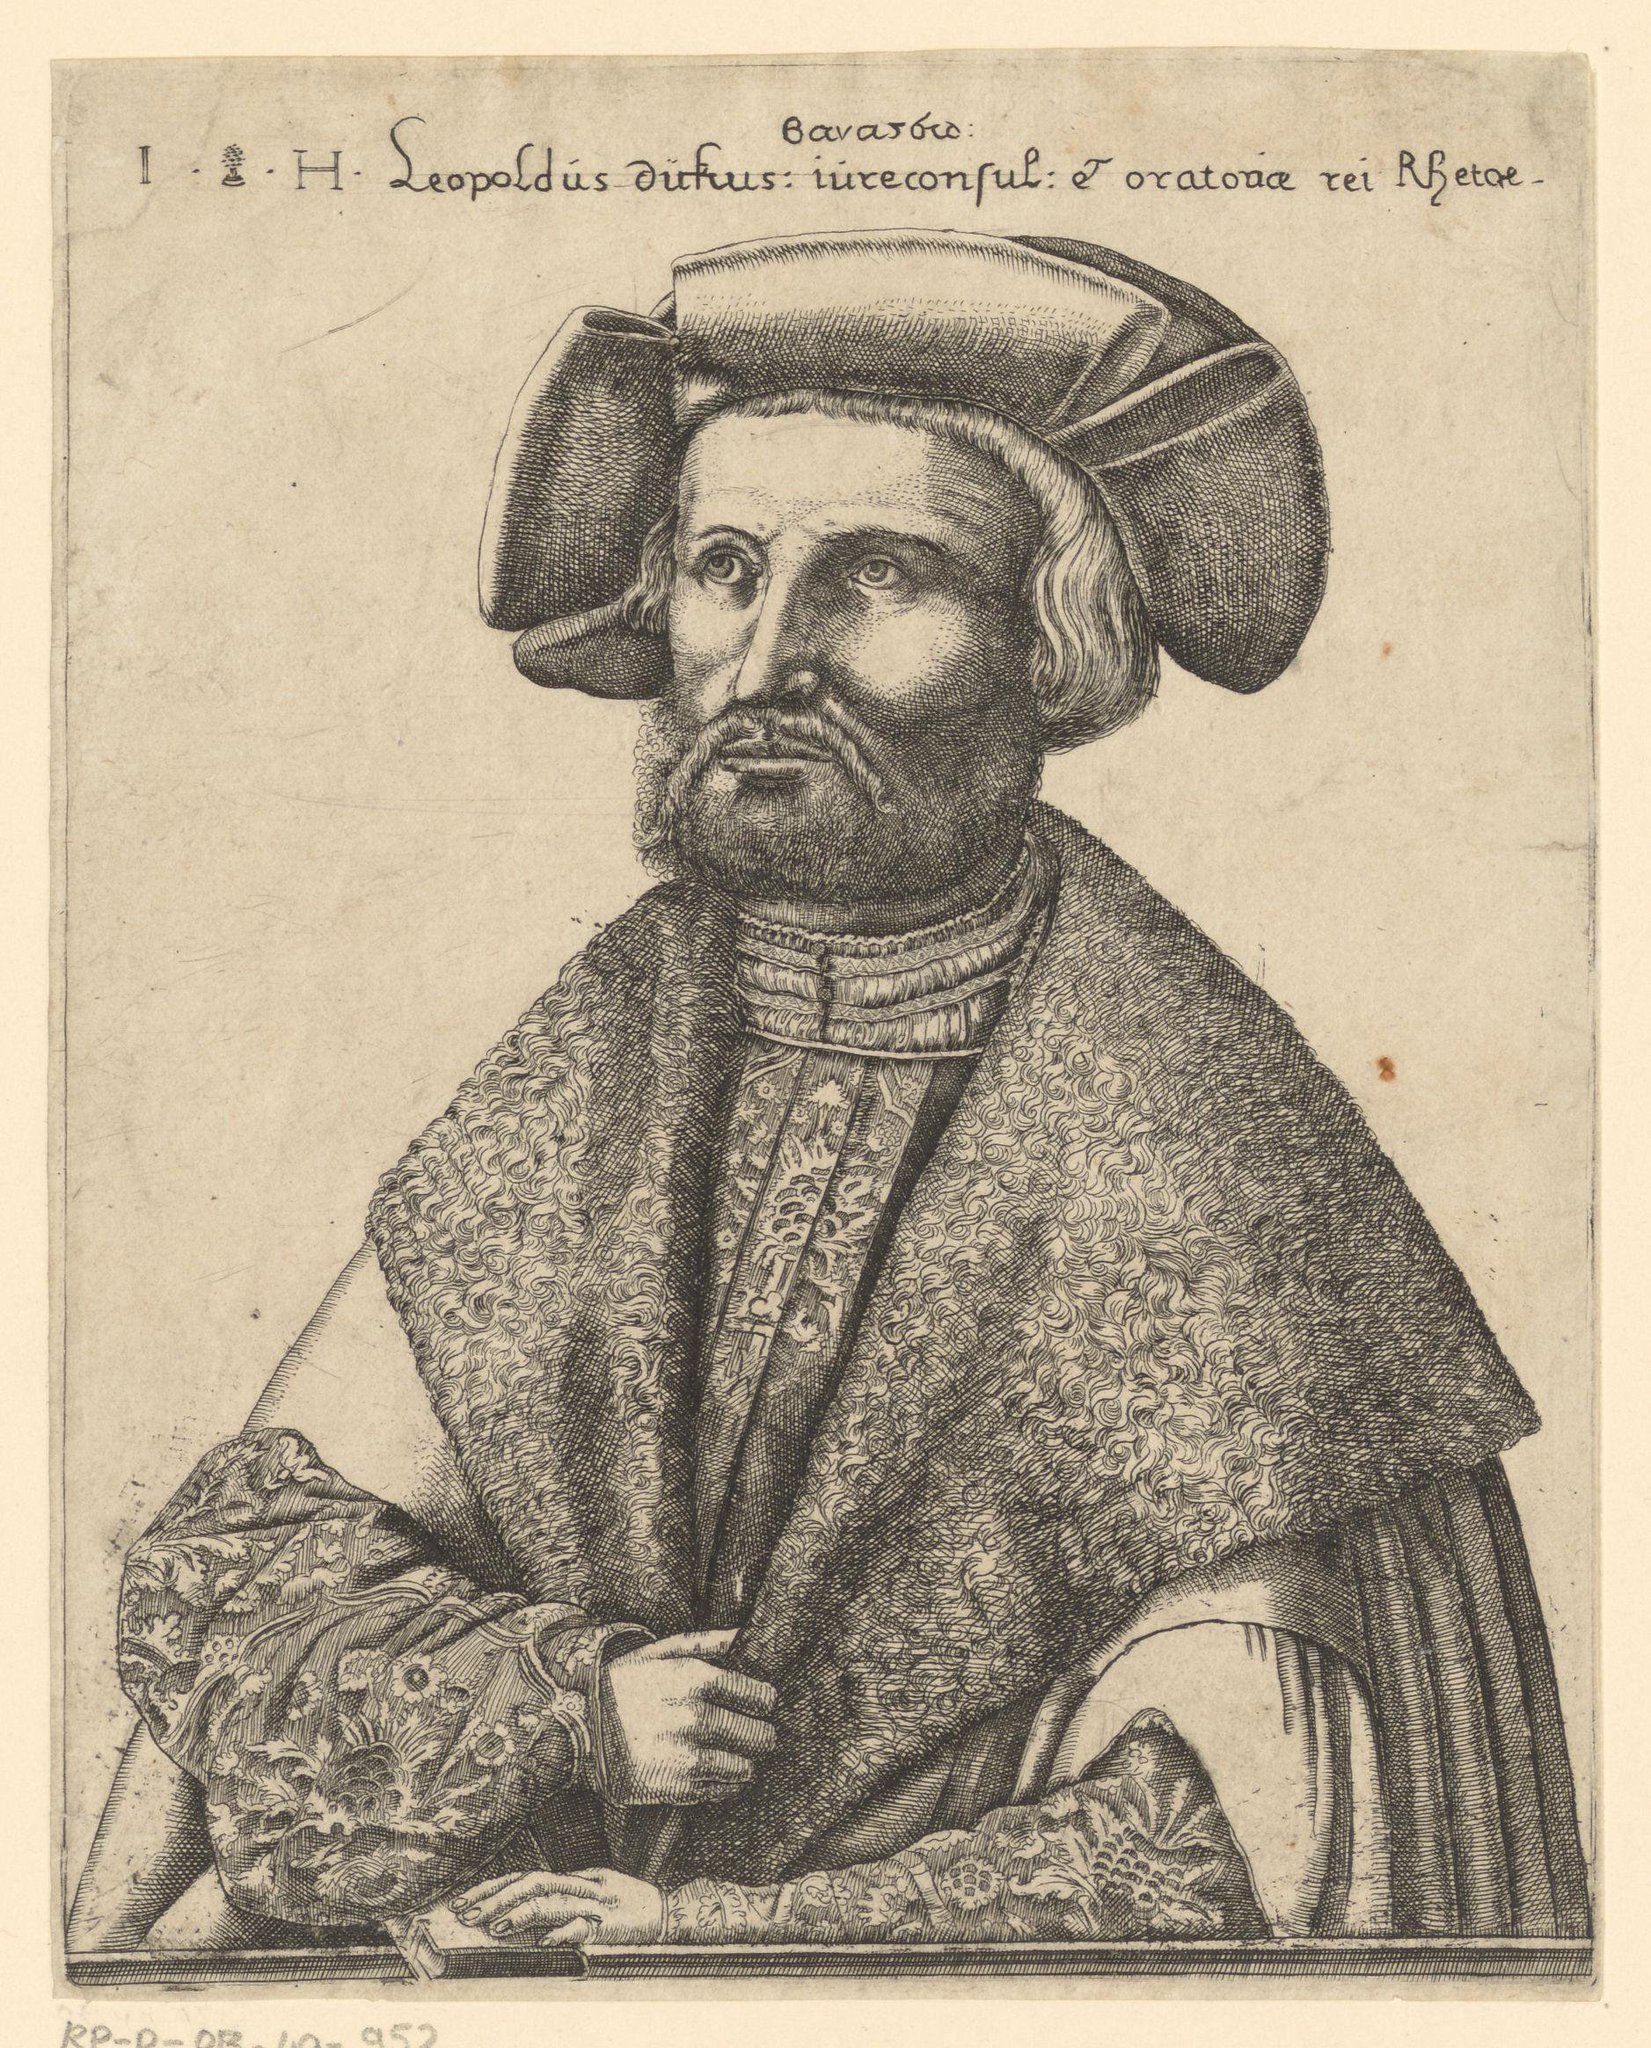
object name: print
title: Portret van Leopold Dick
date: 1530-1600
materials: paper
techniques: etching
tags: historical persons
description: Tekst in het Latijn over Leopold Dick's functie.